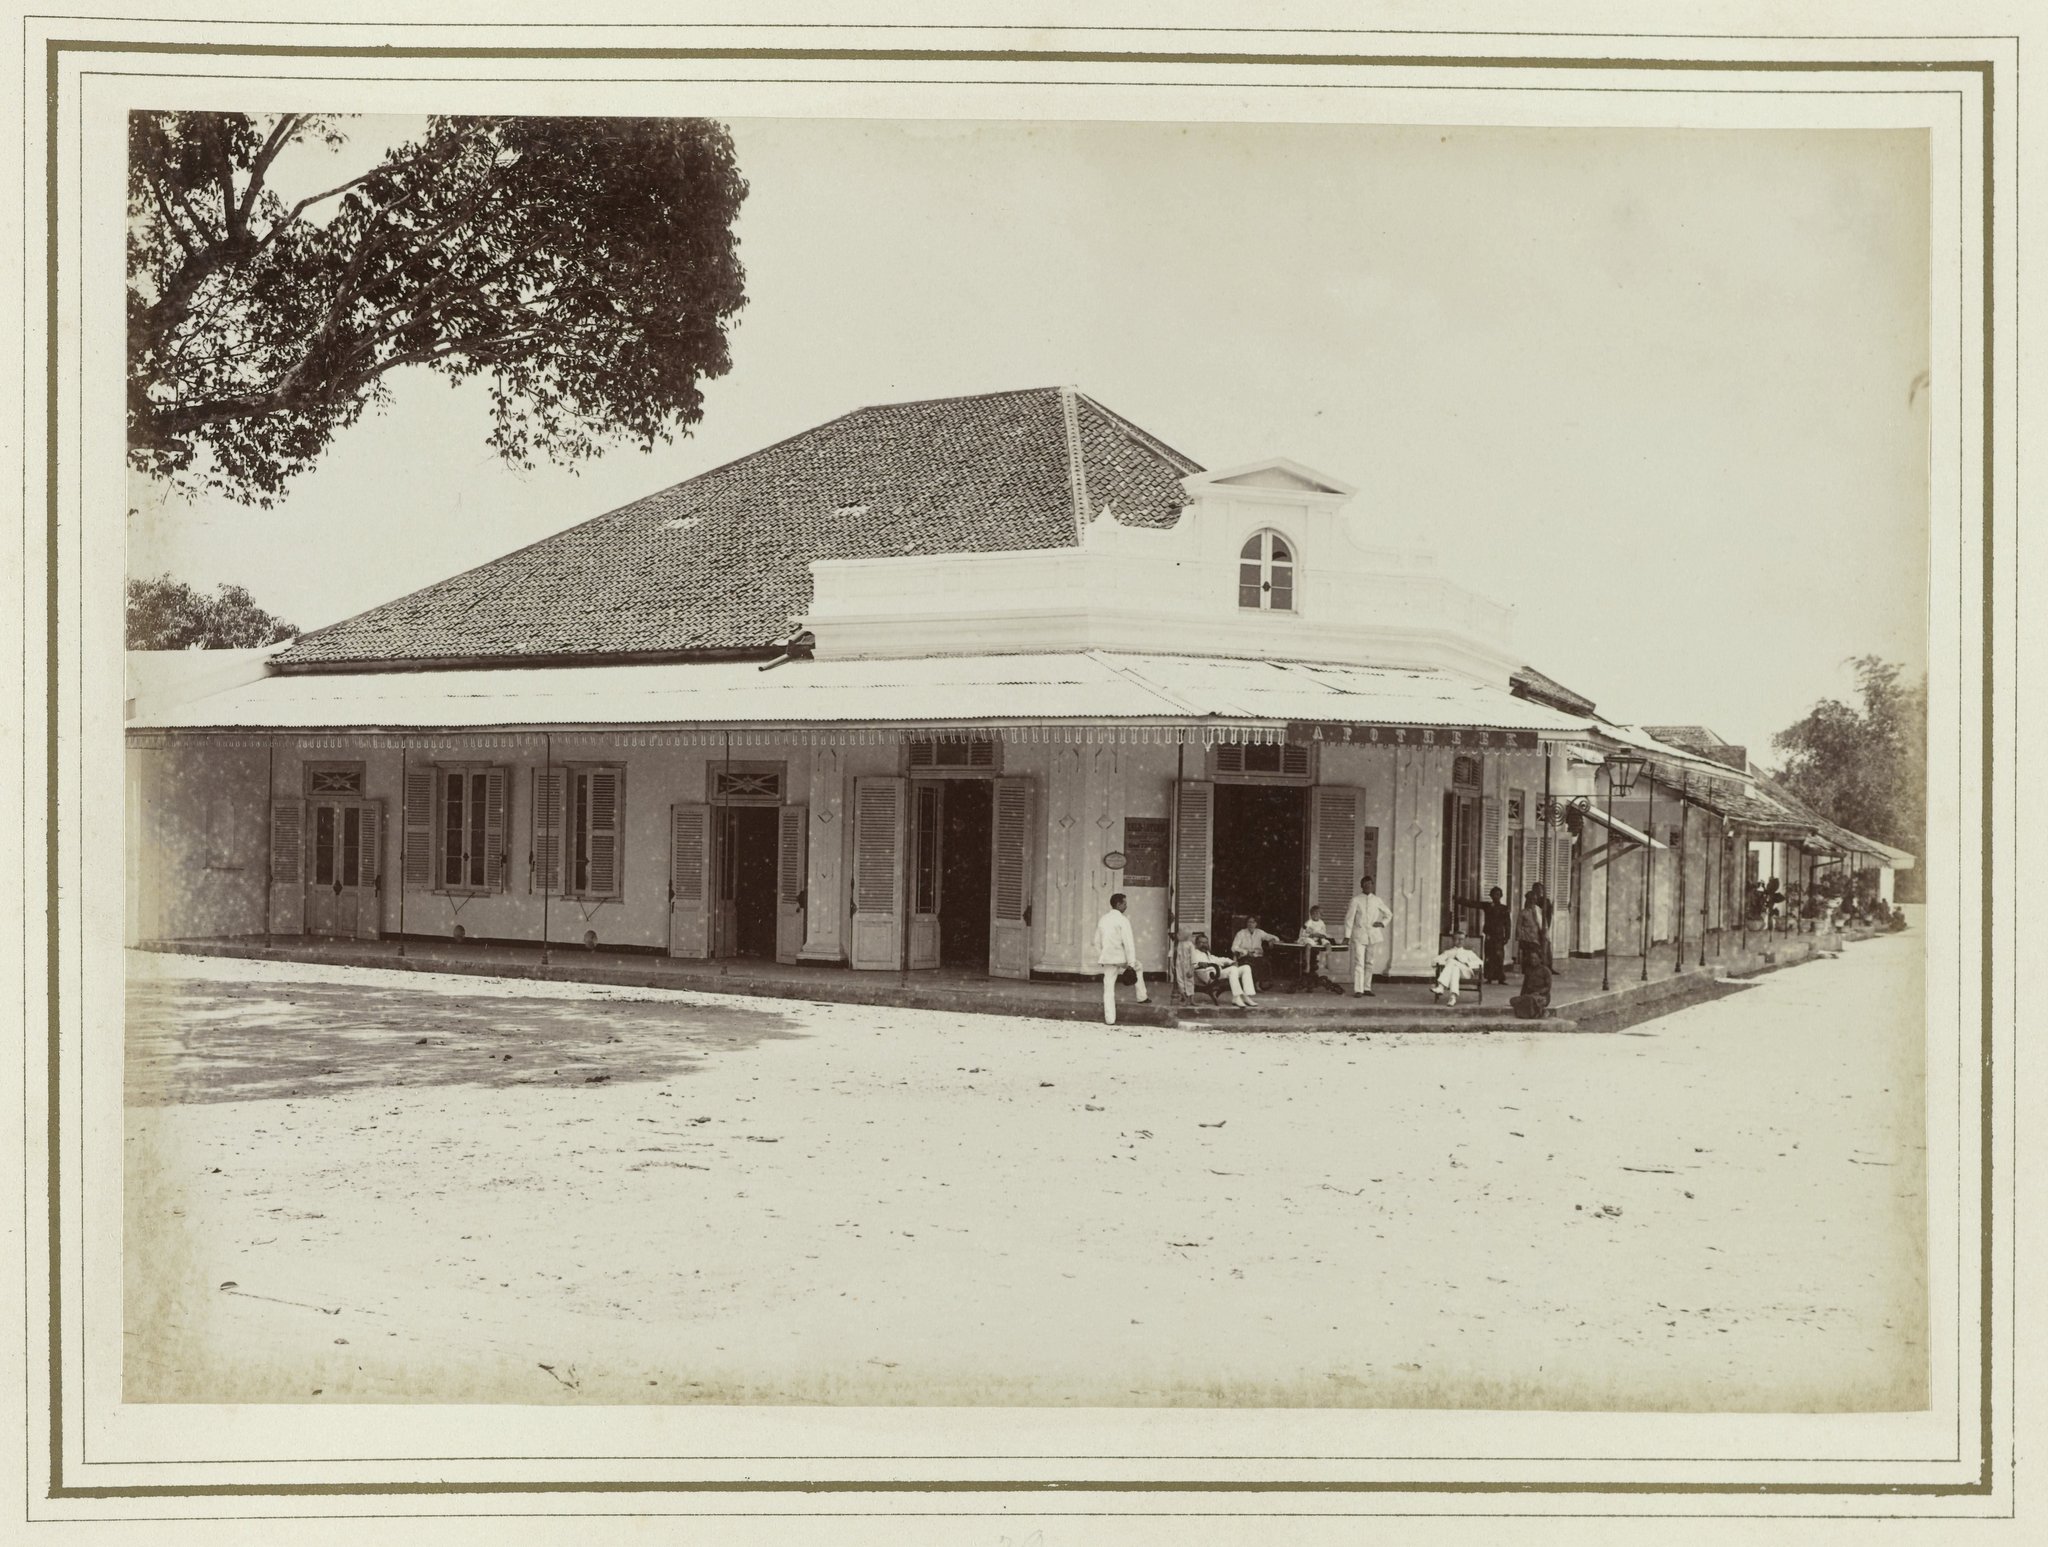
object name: photograph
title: Apotheek van J. van Gorkum & Co.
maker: kassian céphas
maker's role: fotograaf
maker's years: 1845-1912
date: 1886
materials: photographic support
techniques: albumen print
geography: jogjakarta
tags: pharmacist, druggist, apothecary; pharmacy, drugstore, dispensing chemist, edifice, e.g.: public building, department store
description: Een Europees gezin met kinderen voor de apotheek van J. van Gorkum & Co, op de hoek van de Lodji Ketjil Koelon en Apotheekstraat, tegenwoordig de Jalan Sriwedari en de Jalan Diloto, in Jogyakarta. Onderdeel van het fotoalbum aangeboden aan J.M. Pijnacker Hordijk bij zijn vertrek uit Jogyakarta in 1886.